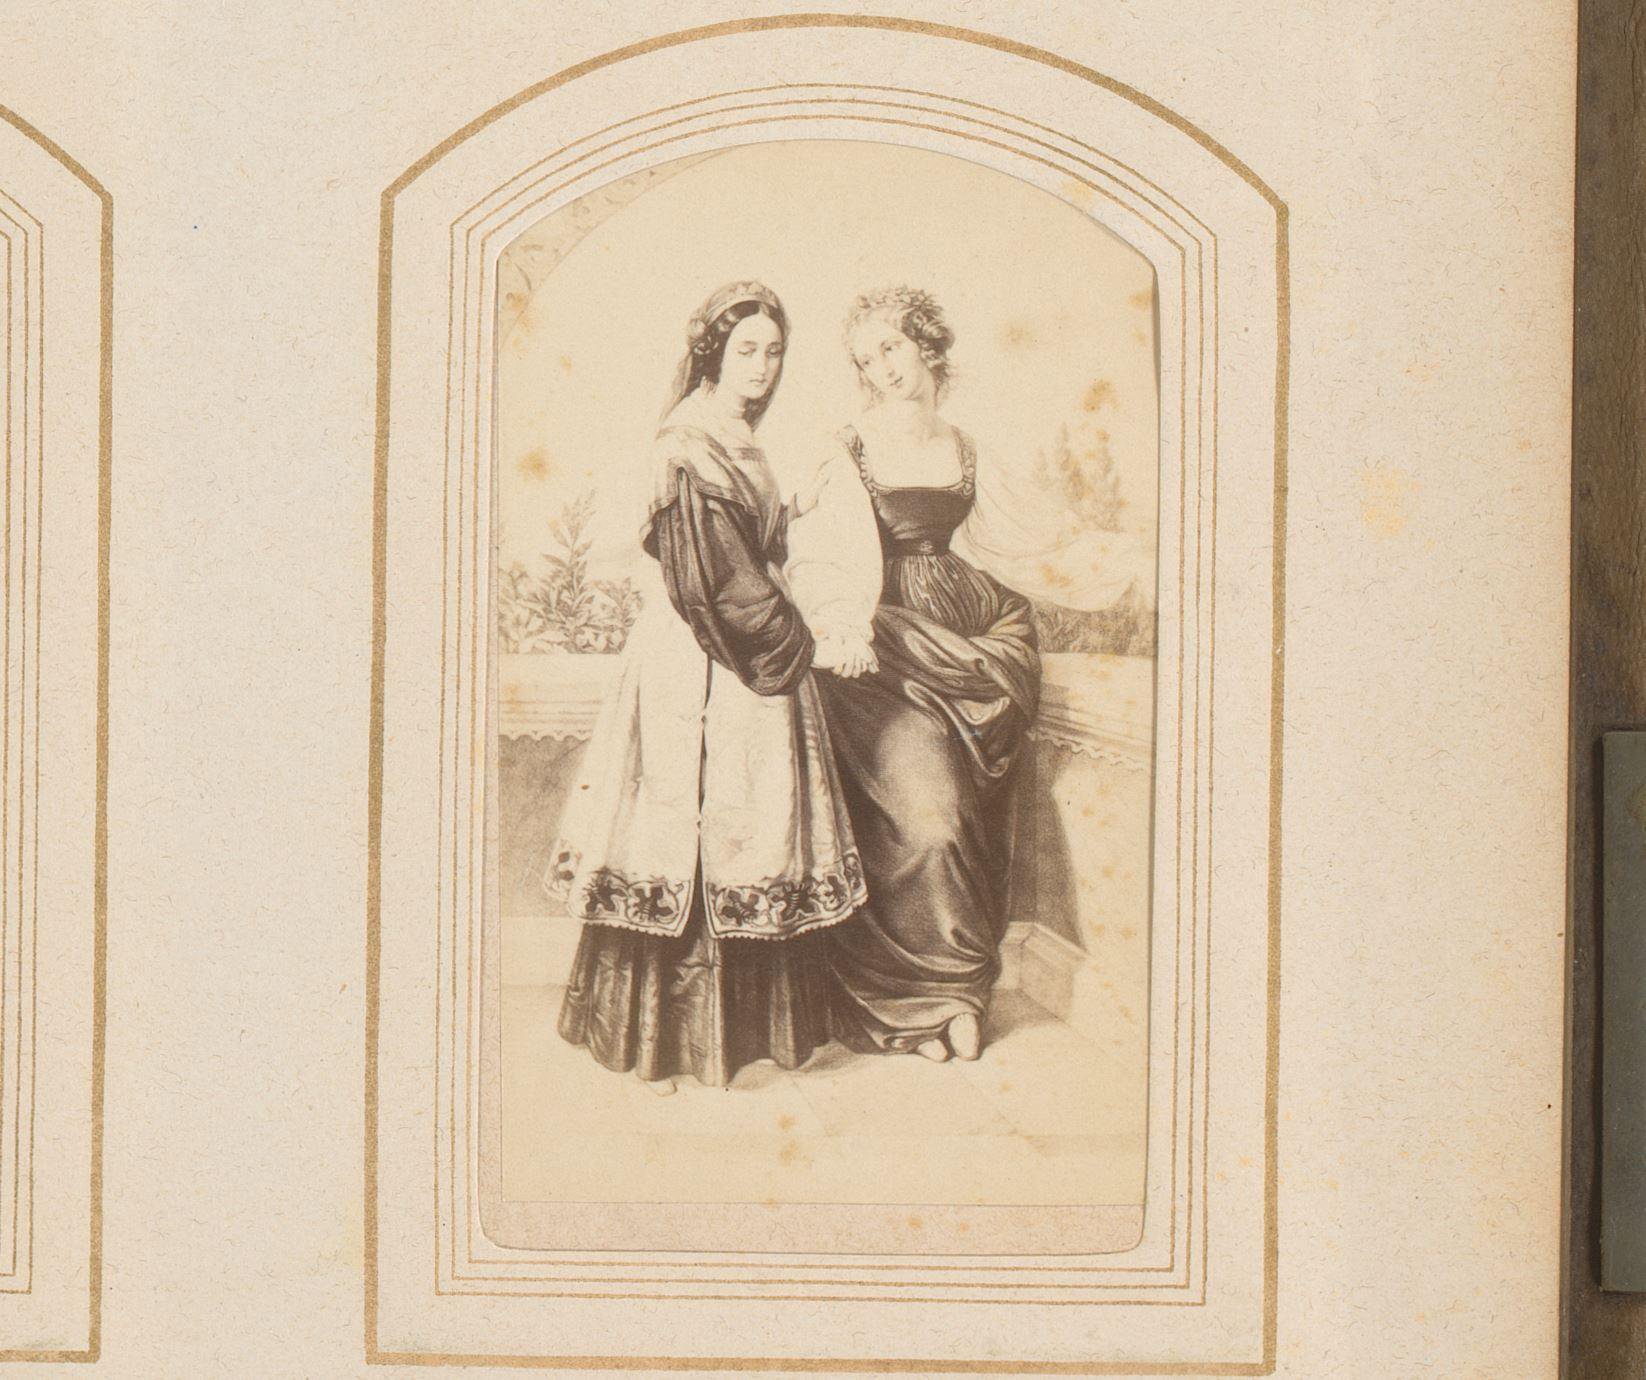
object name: album leaf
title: Fotoreproductie van Die beiden Eleonoren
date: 1870-1900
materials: cardboard, photographic support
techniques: albumen print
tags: adult woman, painting, drawing and the graphic arts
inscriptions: annotation: ‘Die beiden Eleonores’, inscription: ‘Carl Sohn/2903/ Les deux Eleonores./ Die beiden Eleonoren./(...)’